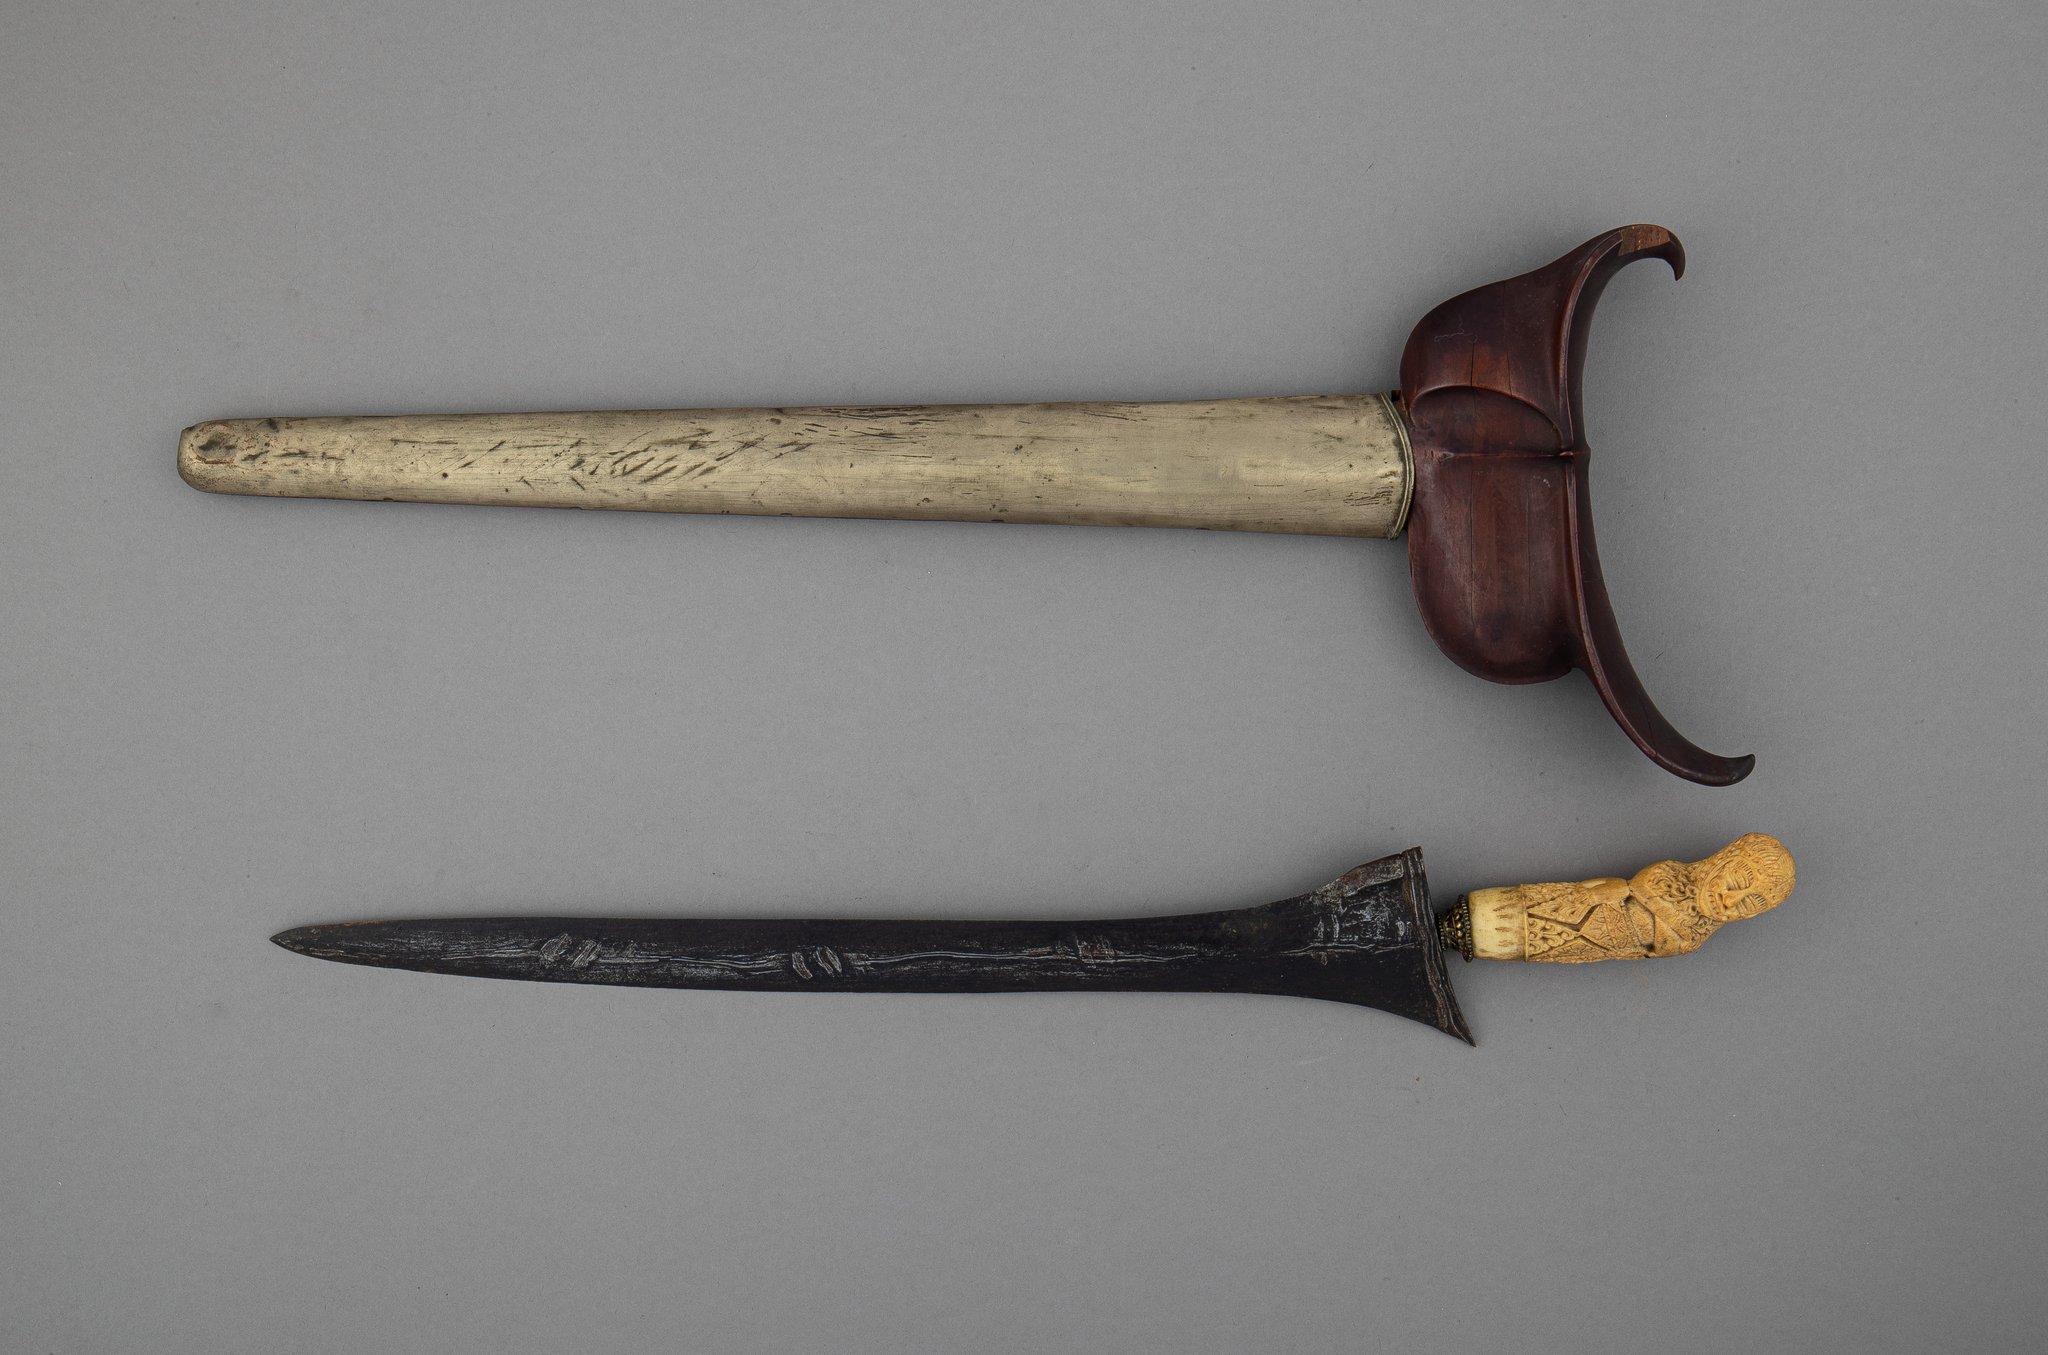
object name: kris with sheath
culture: madurese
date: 1501-1900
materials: copper alloy, ivory, steel, wood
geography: indonesia